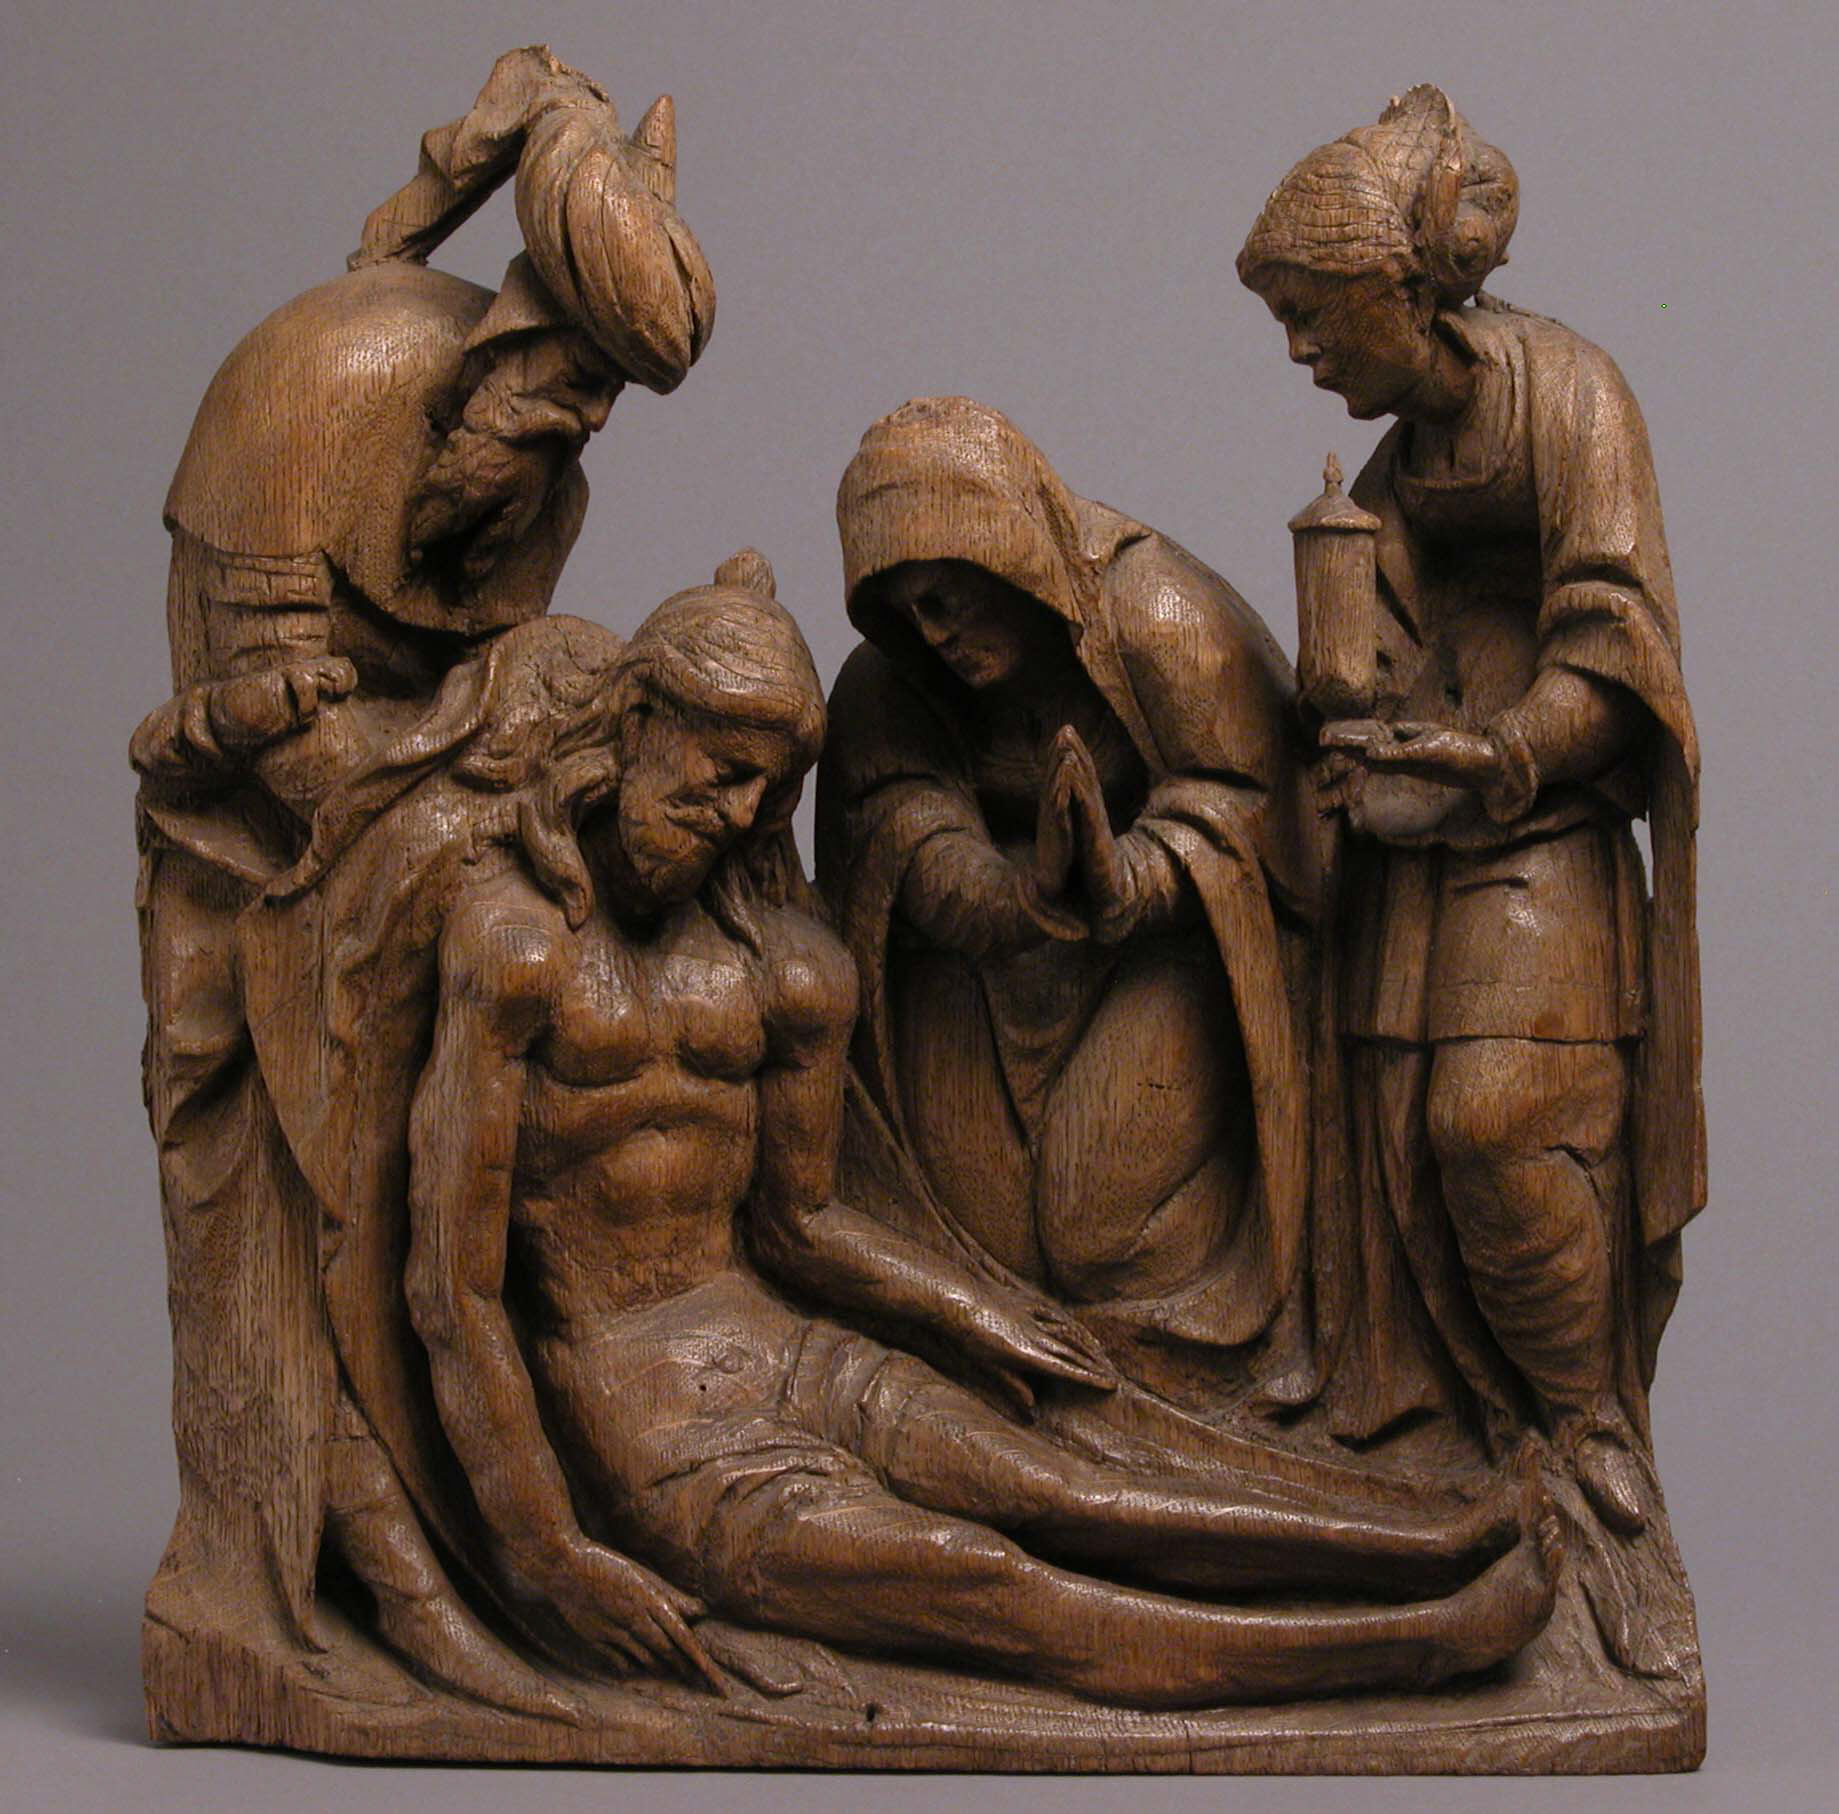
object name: statue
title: Pietà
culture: south netherlandish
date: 1515-1520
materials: wood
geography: antwerp (?)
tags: christ,mary magdalene,virgin mary